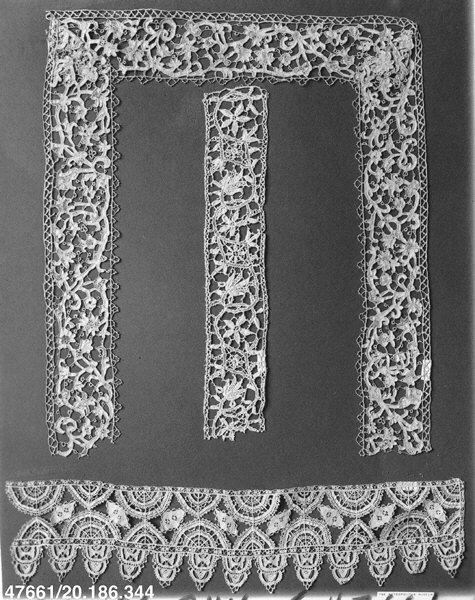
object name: border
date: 1601-1700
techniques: lace